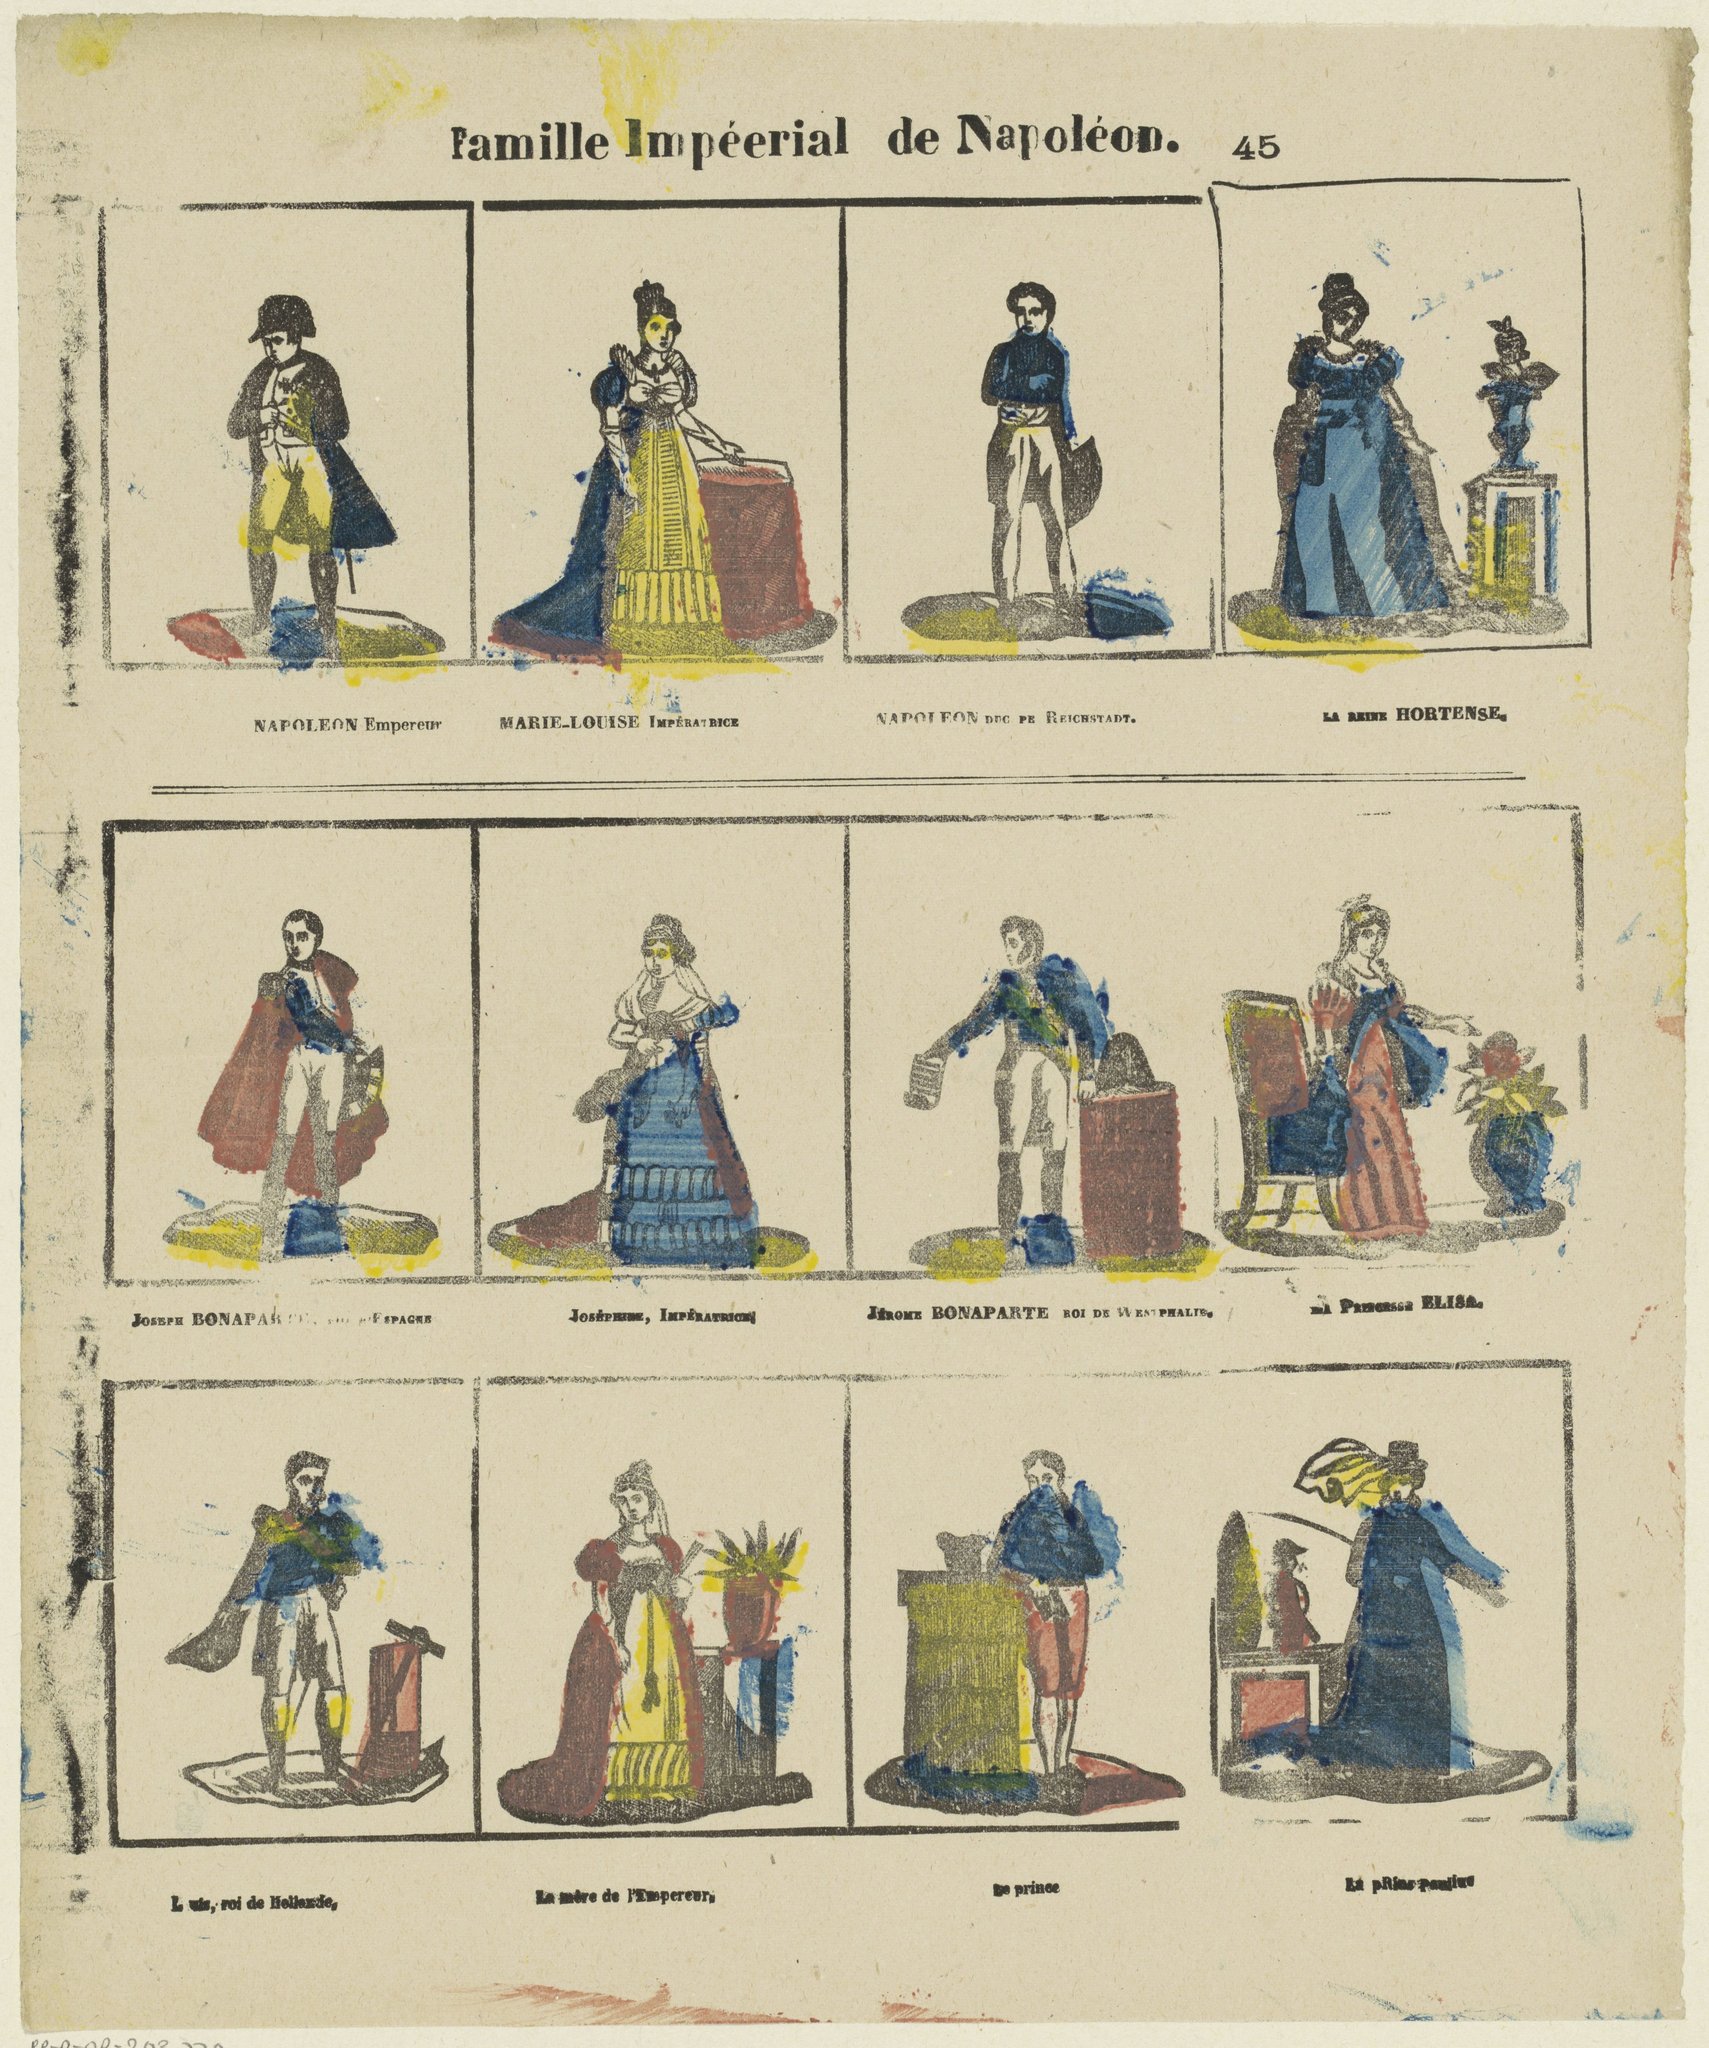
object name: print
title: Famille Impéerial de Napoléon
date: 1827-1894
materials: paper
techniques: colour, letterpress printing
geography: schaarbeek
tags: paris, napoleon i (emperor of the french), family, relationship, descent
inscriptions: collector's mark: Lugt 2760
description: Blad met 12 voorstellingen van familieleden van Napoleon I Bonaparte. Onder elke afbeelding een onderschrift in het Frans. Genummerd rechtsboven: 45.